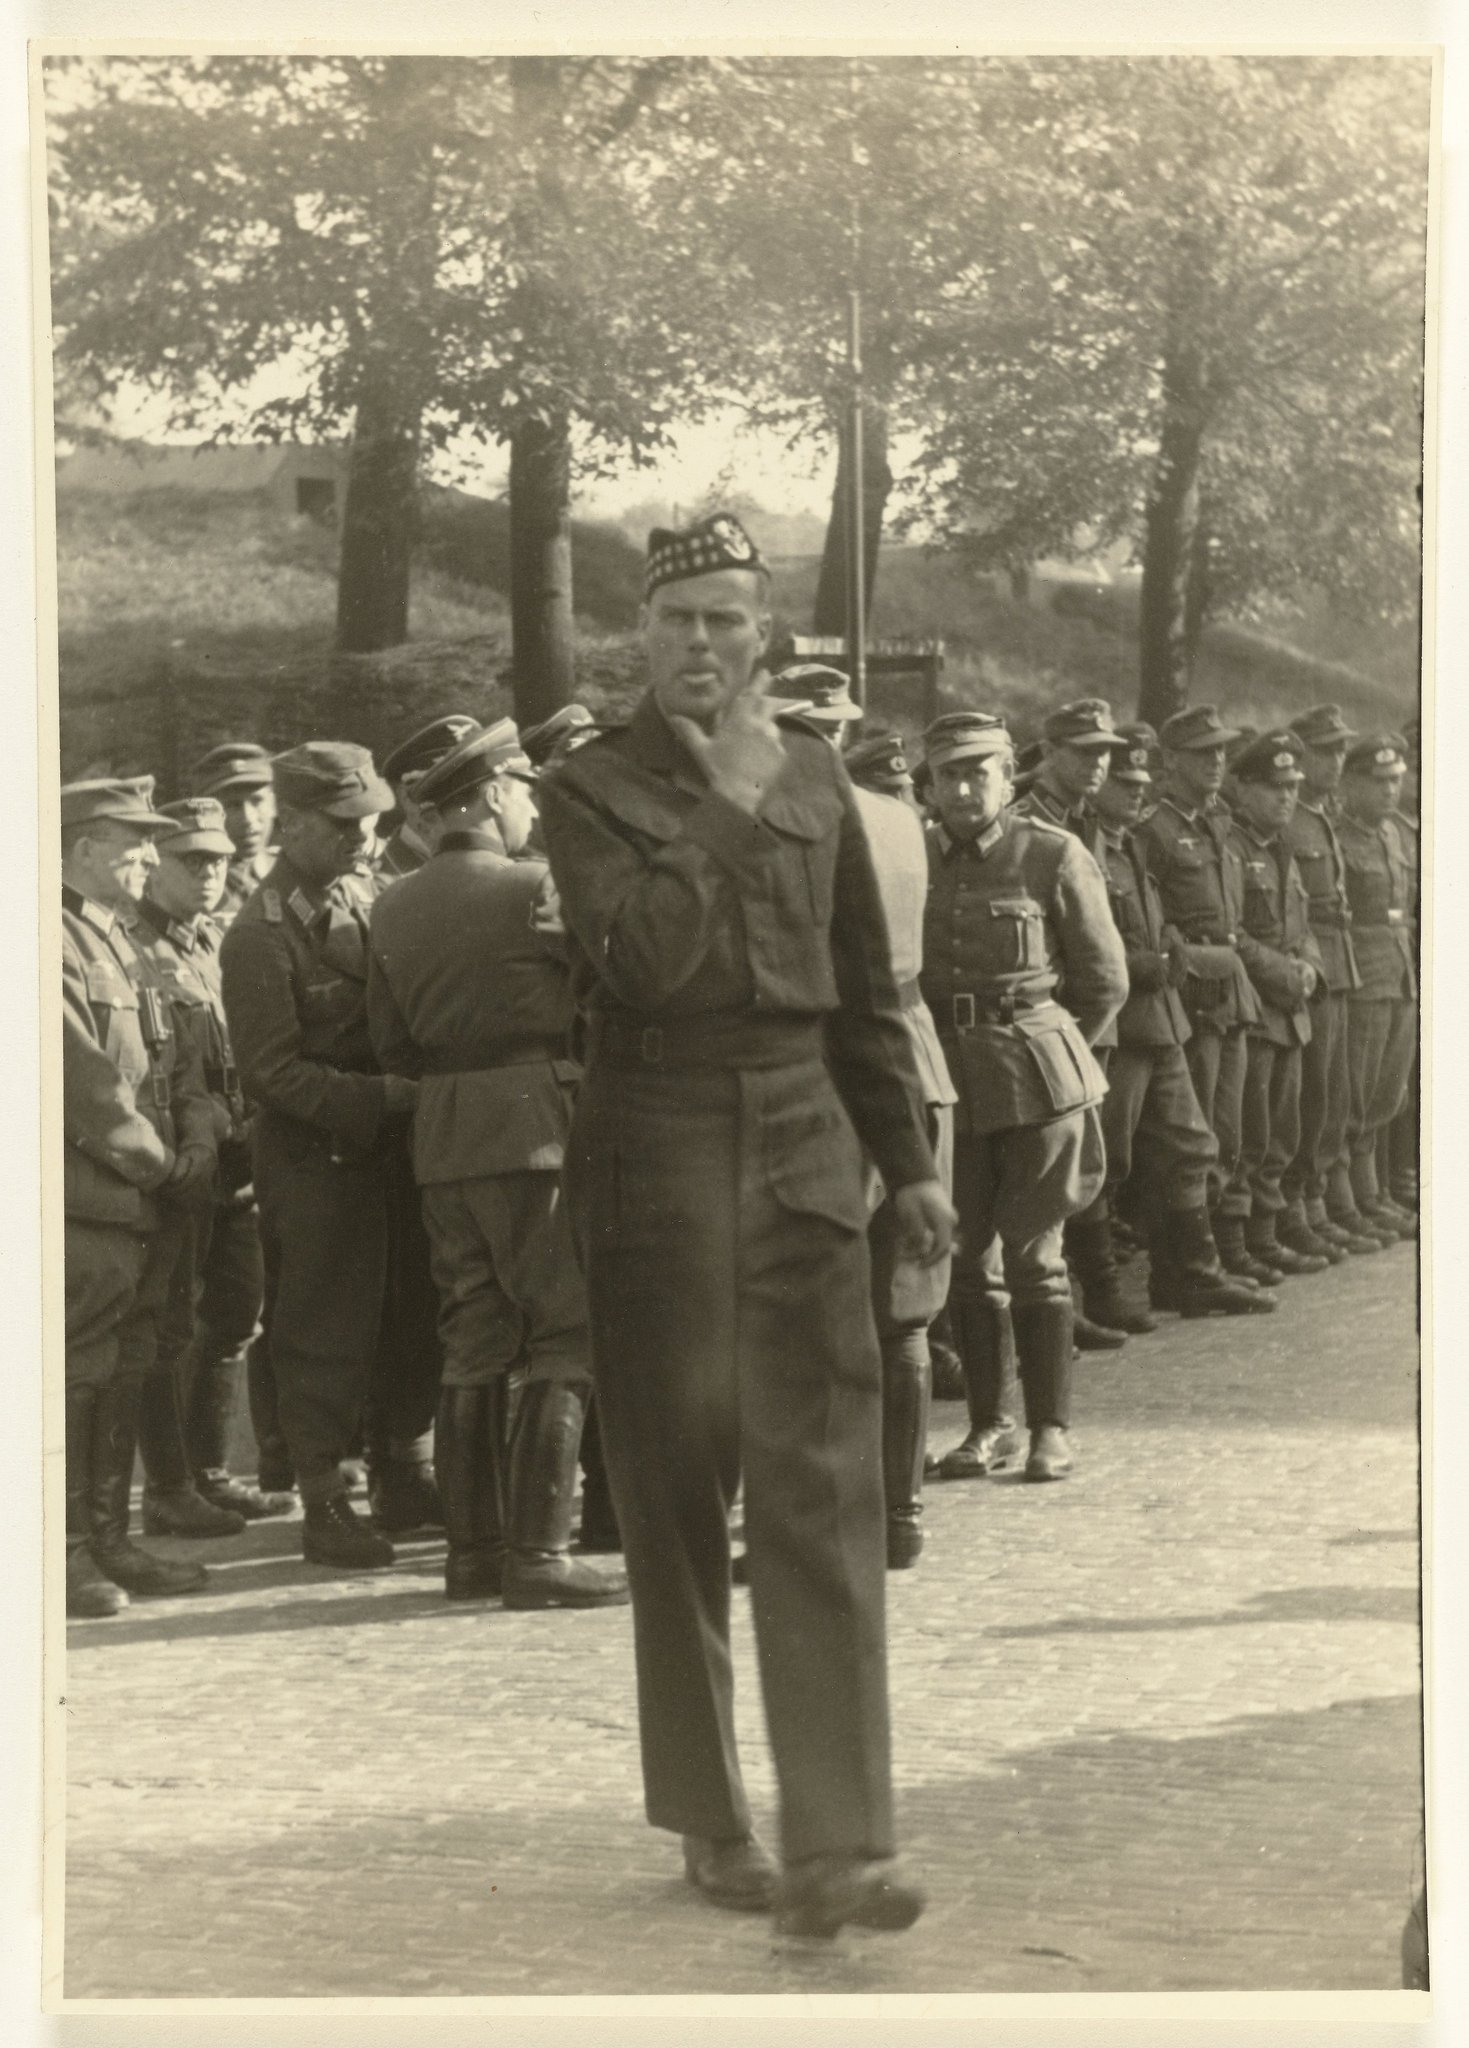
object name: photograph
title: Krijgsgevangen Duitsers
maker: Anonymous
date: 1905-1945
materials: photographic support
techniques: photography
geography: netherlands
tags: prisoner of war (after the battle), netherlands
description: Duitse krijgsgevangenen bewaakt door Engelse? militairen.